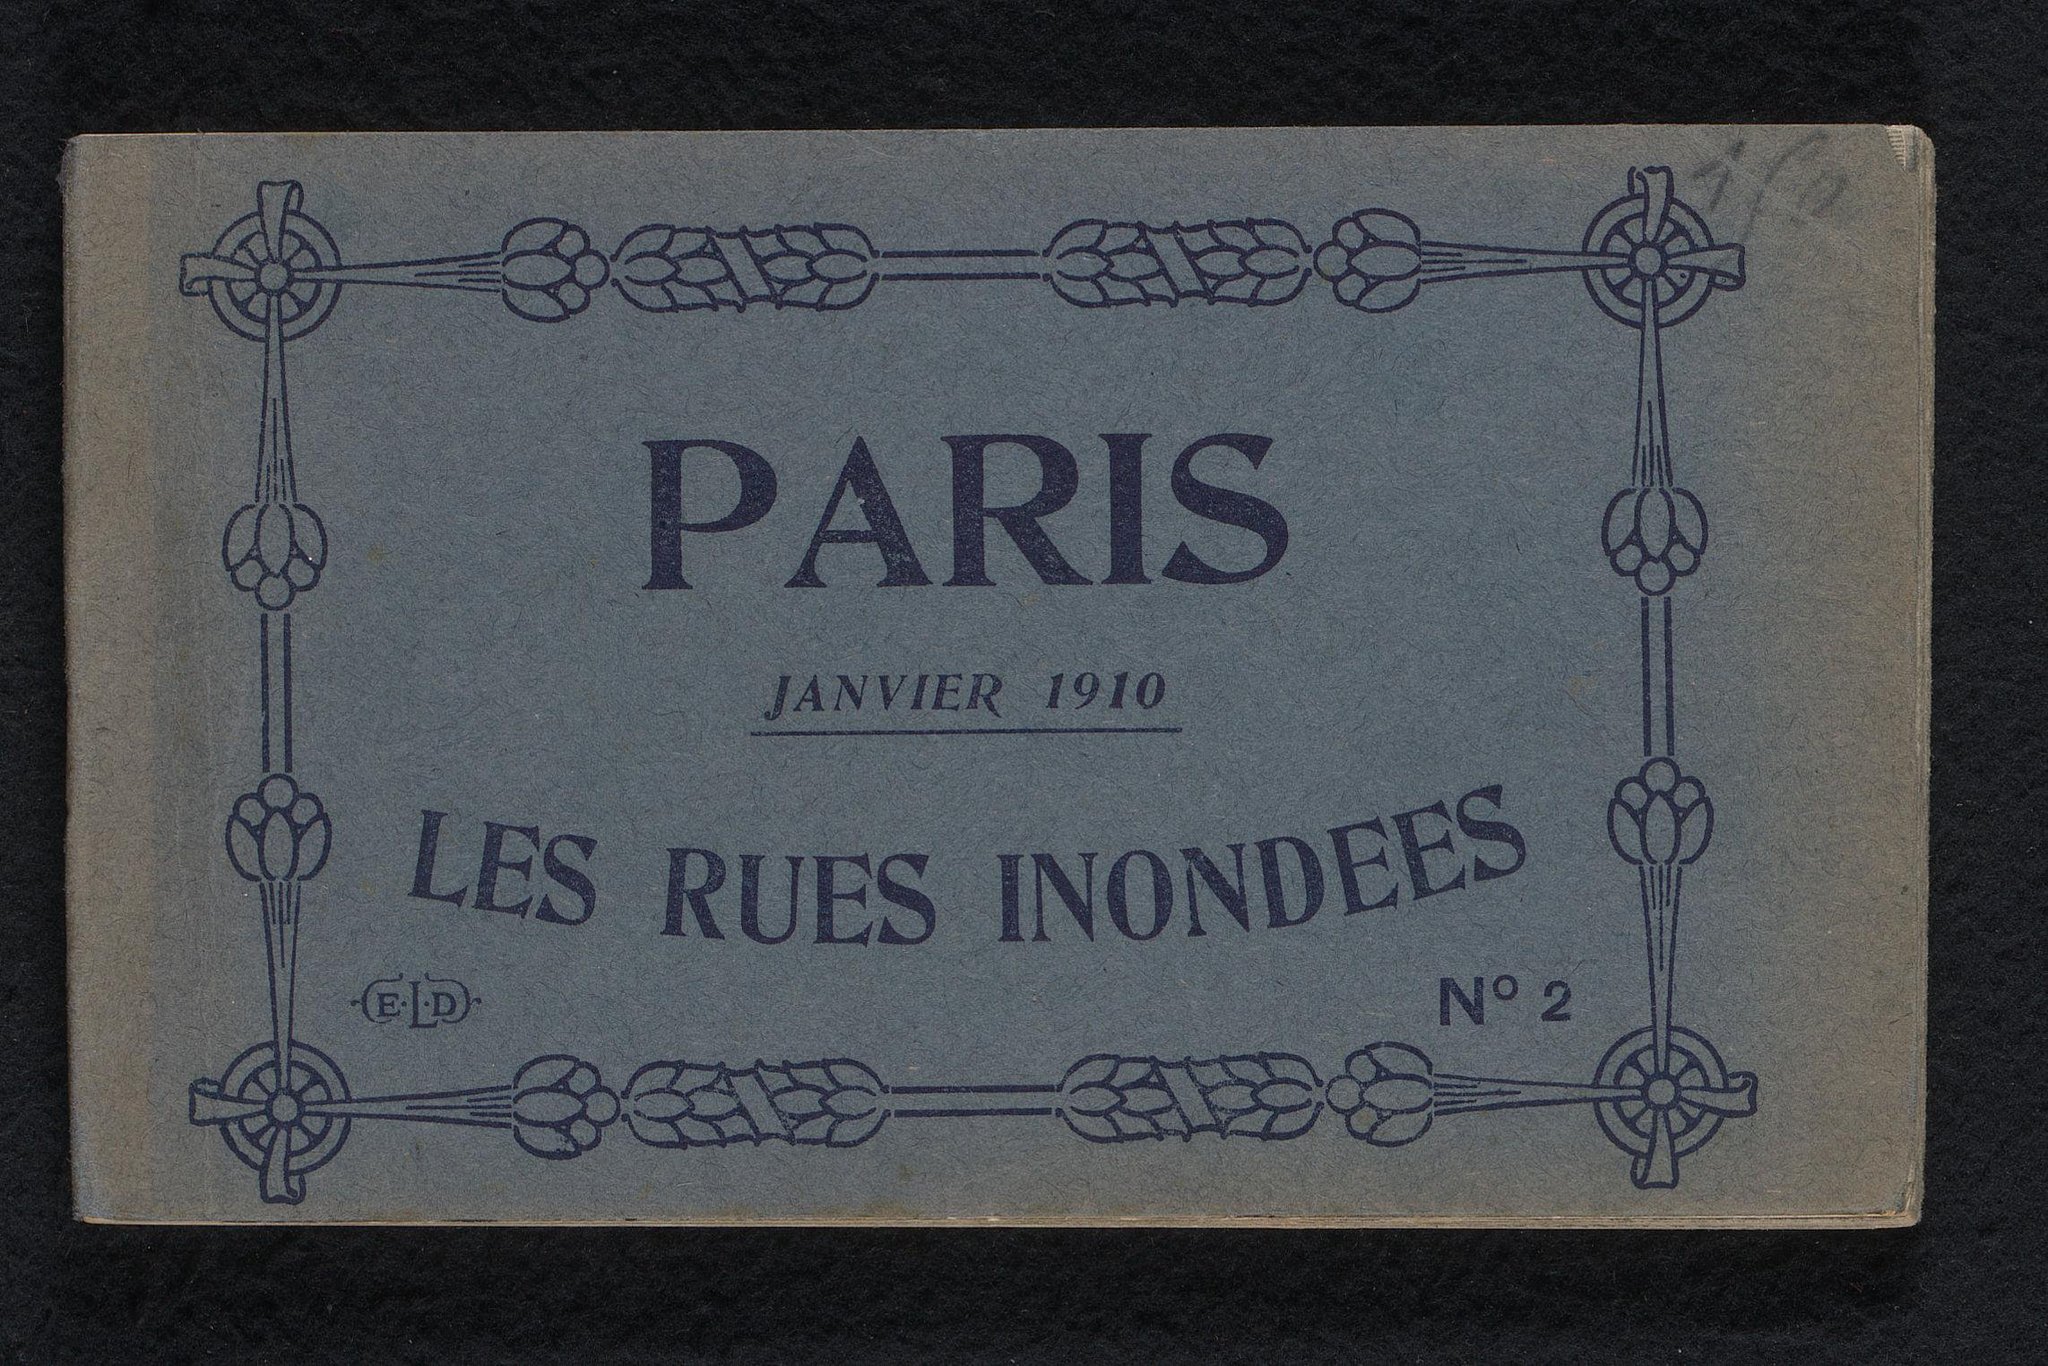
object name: album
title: Album met voorstellingen van de overstroming van Parijs in 1910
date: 1910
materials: cardboard, paper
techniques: photograph, lithograph, stapling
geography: paris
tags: flood, paris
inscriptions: date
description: Album met 24 prentbriefkaarten van de overstroming van Parijs in januari 1910. De prentbriefkaarten kunnen eruit gescheurd worden.